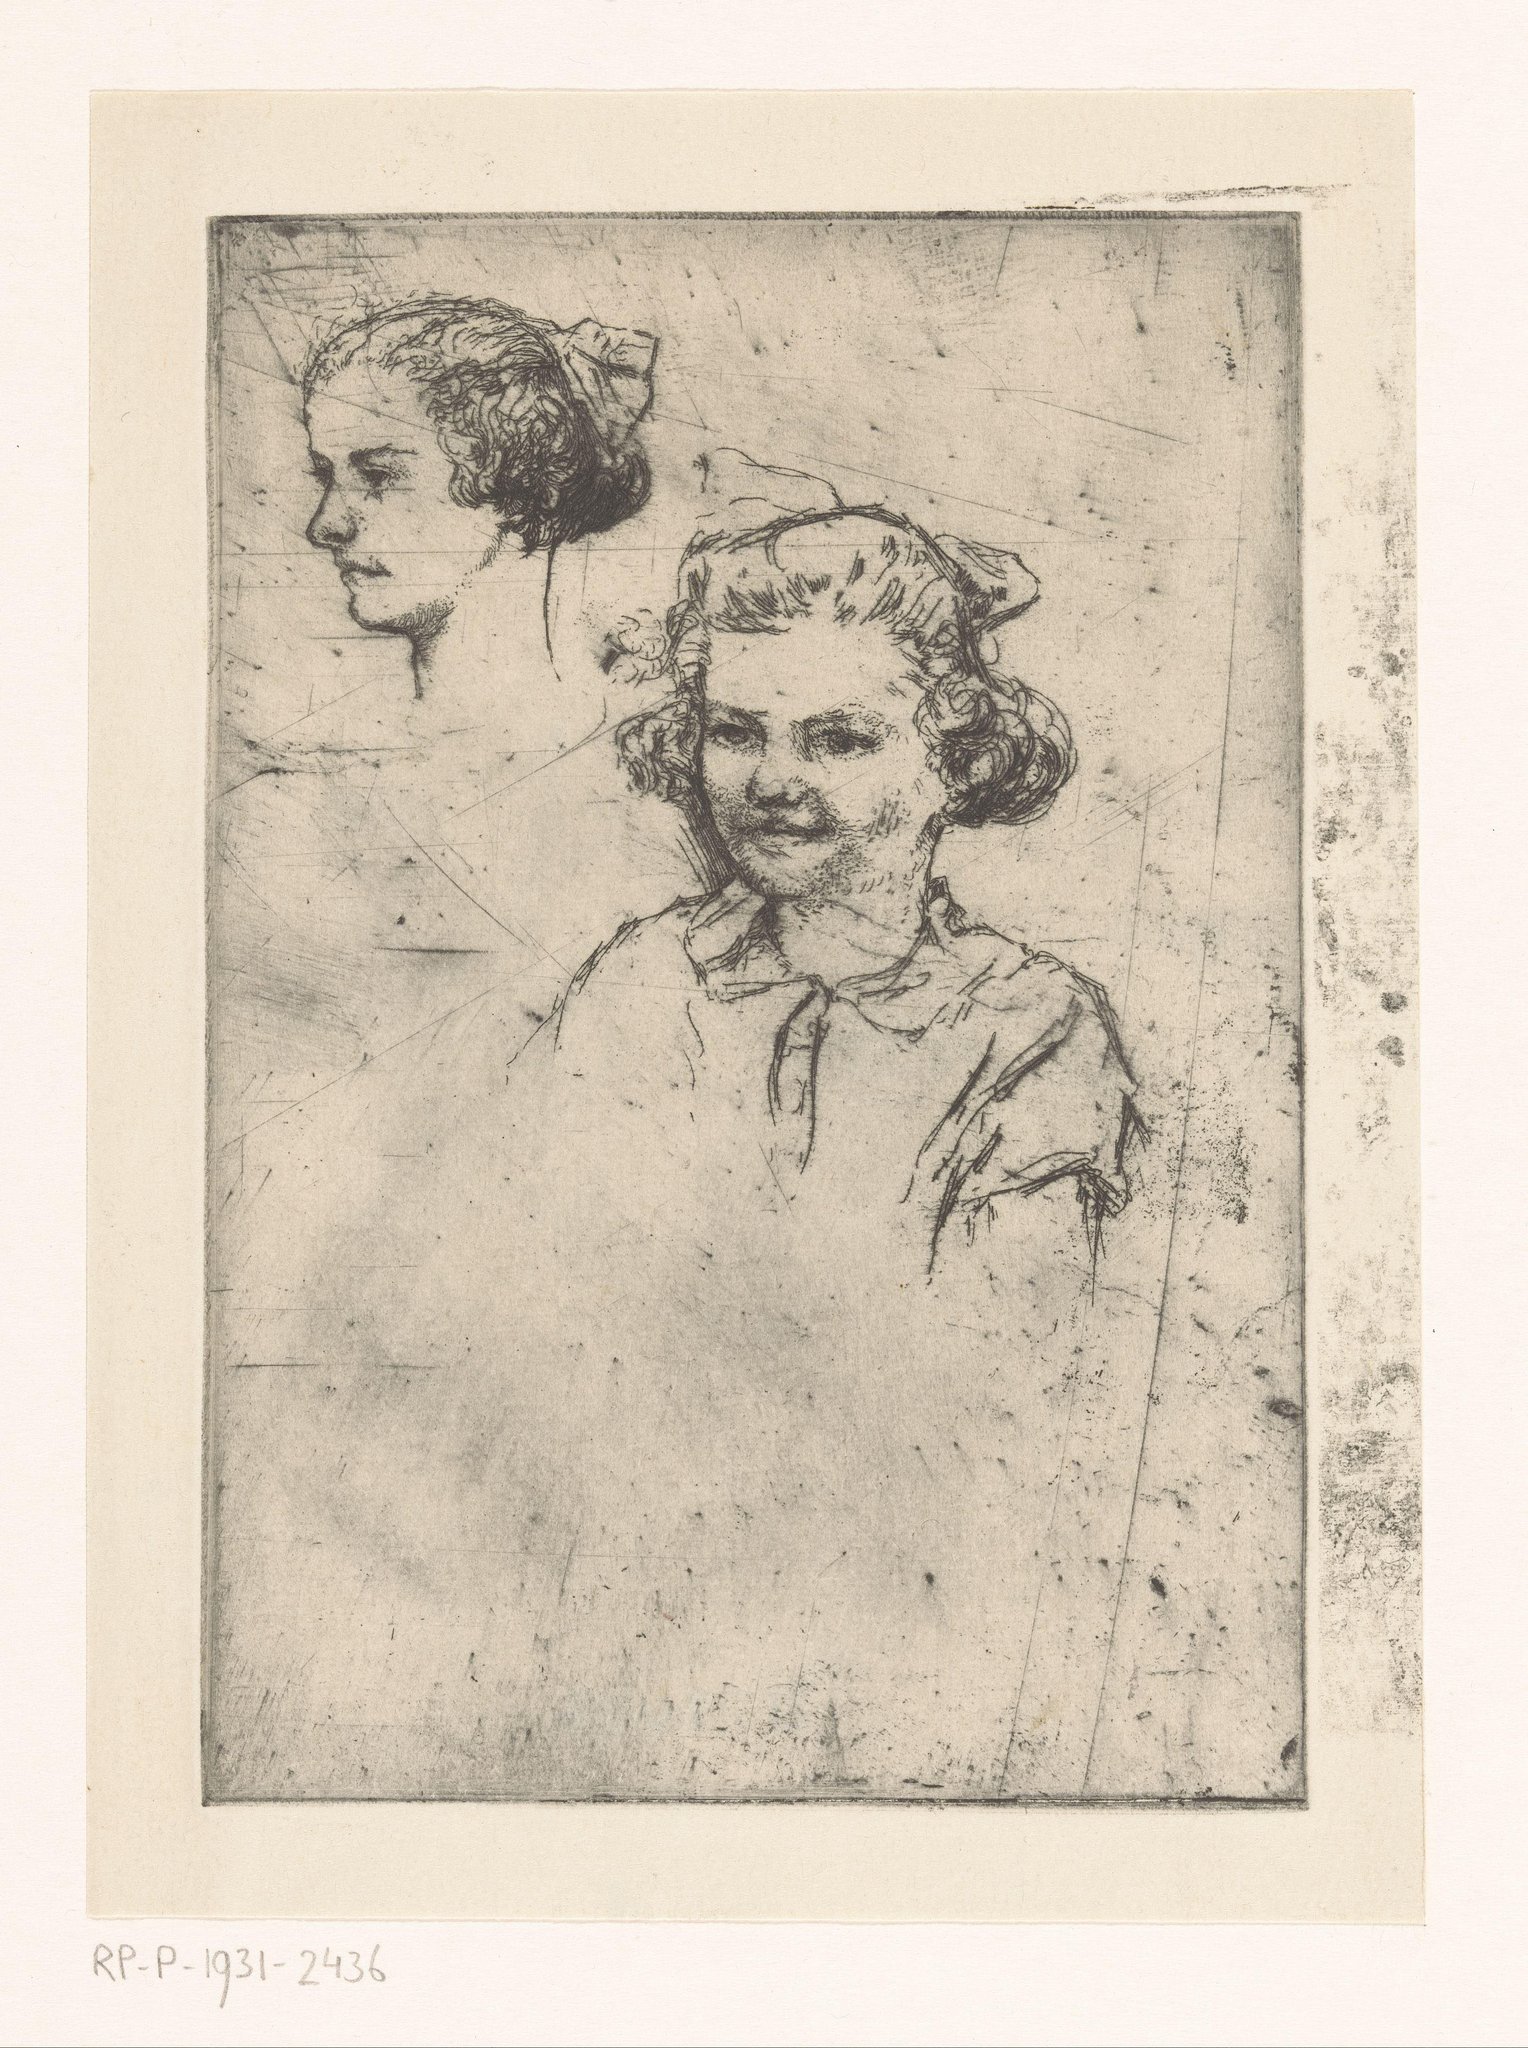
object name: print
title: Twee studies van een meisjeshoofd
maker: johannes löhr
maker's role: print maker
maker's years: 1882-1928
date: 1892-1928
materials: paper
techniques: etching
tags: girl (child between toddler and youth)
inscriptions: collector's mark: Lugt 2228